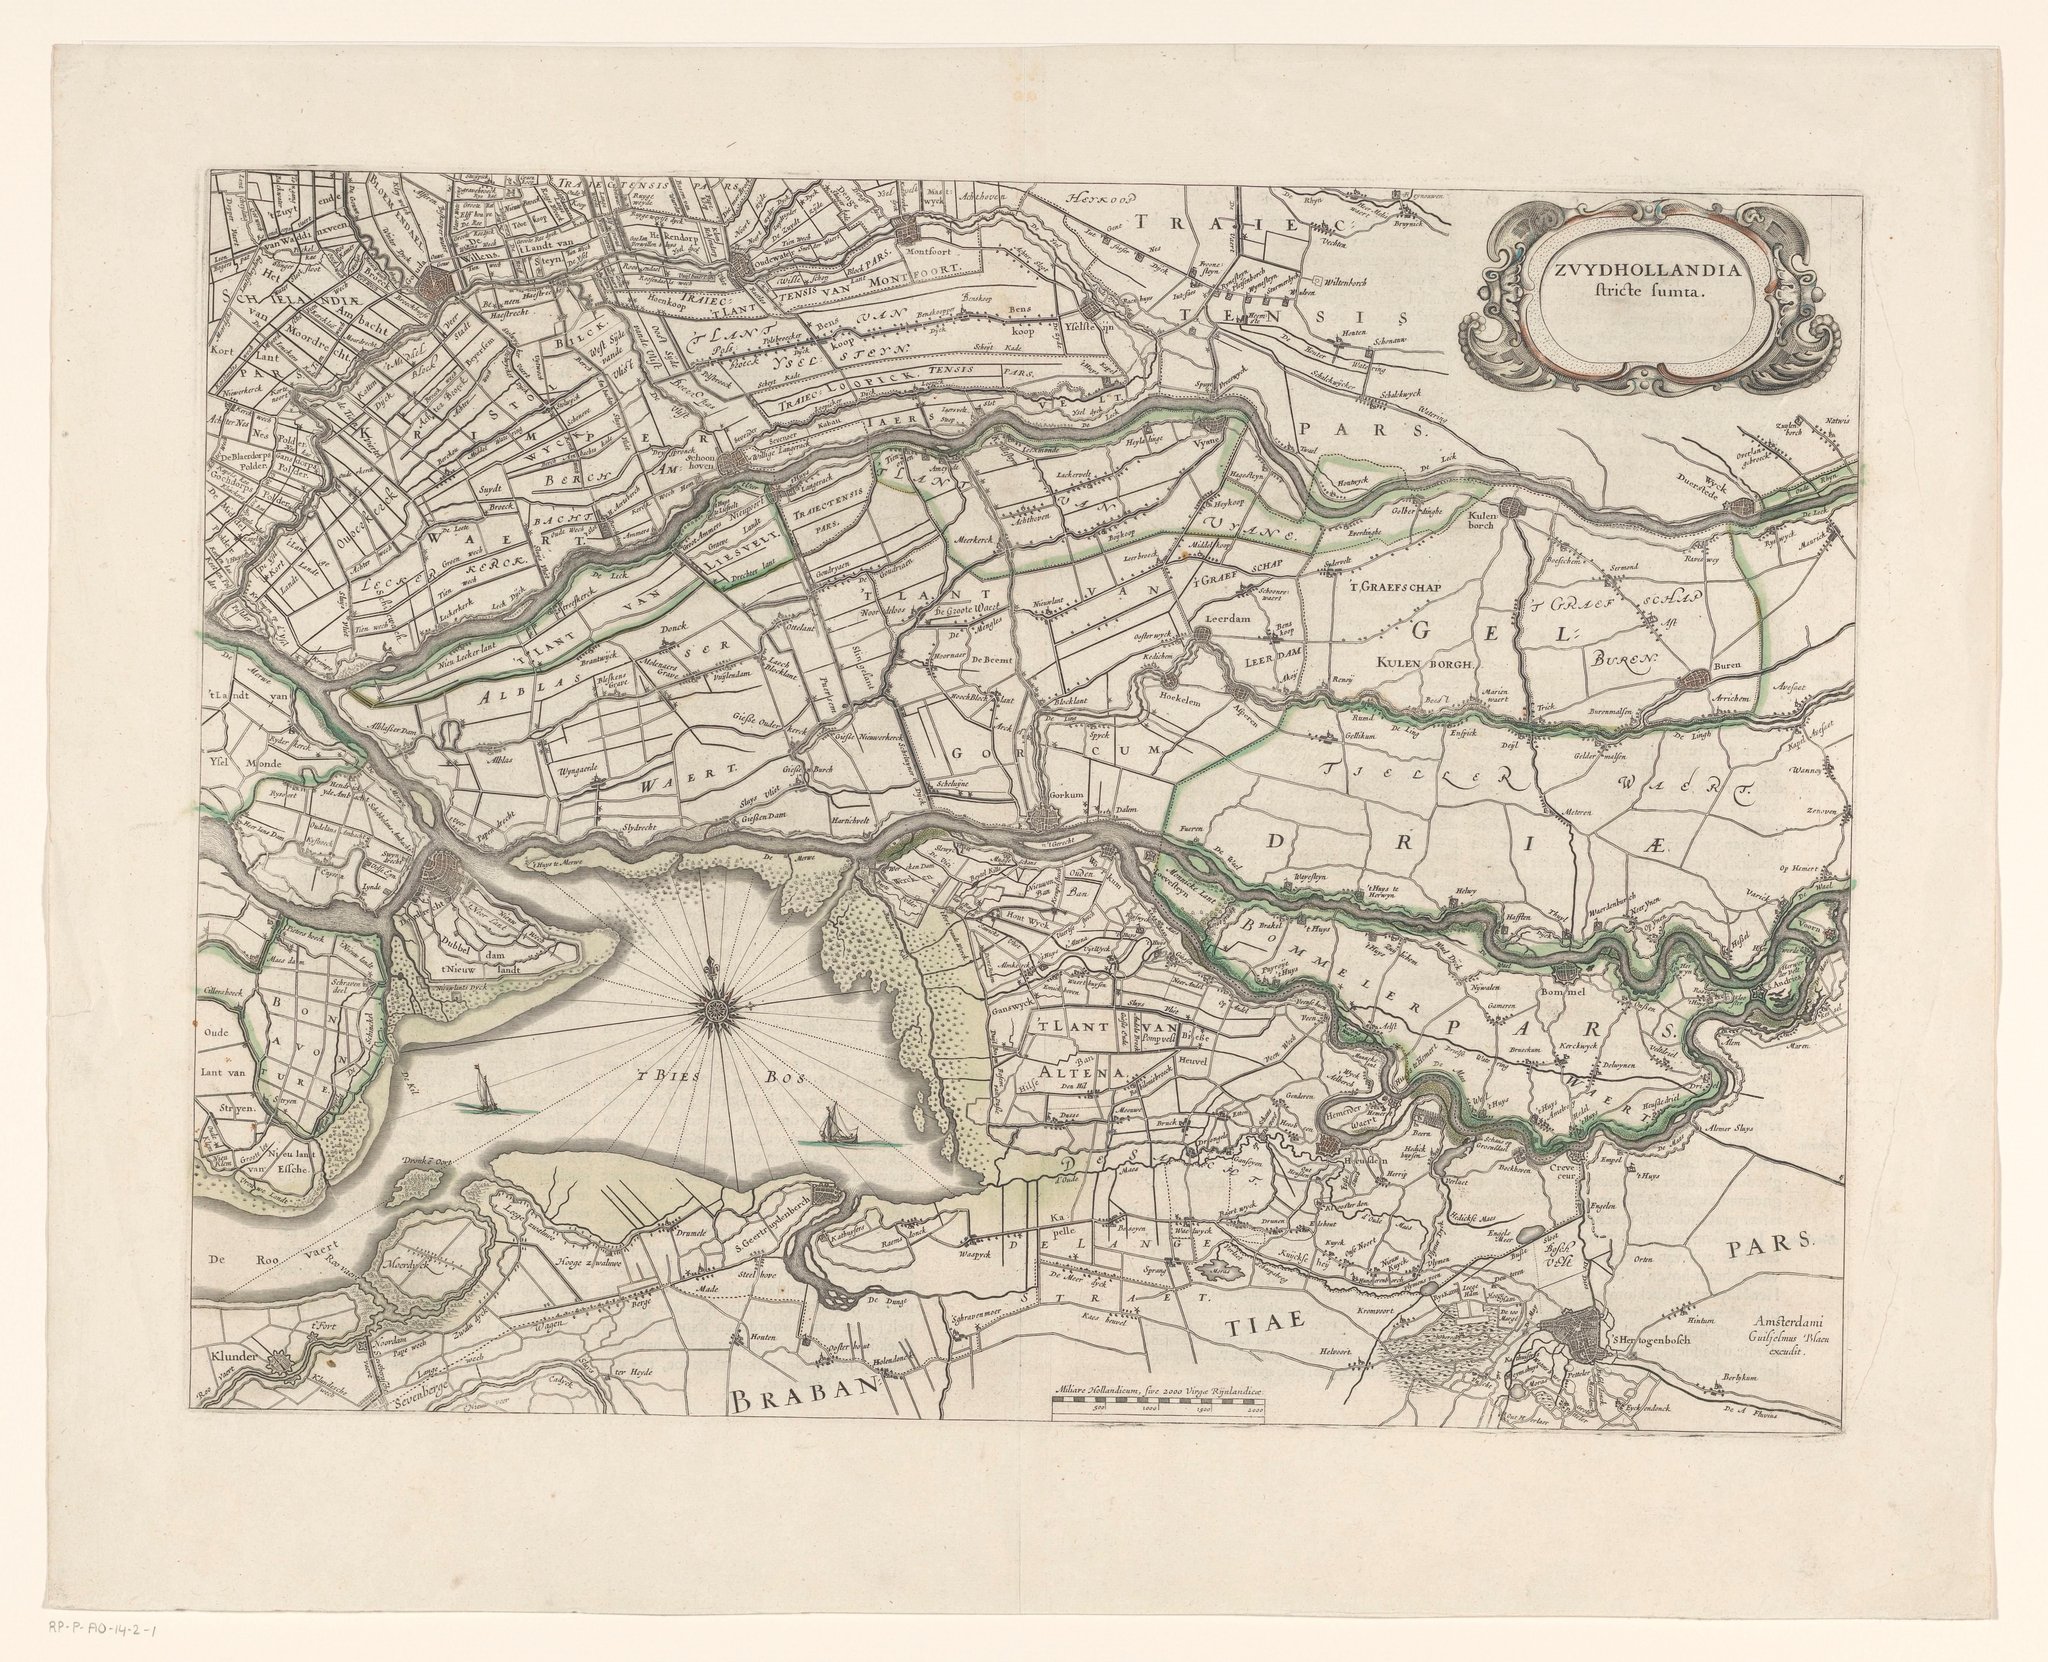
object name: map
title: Zuydhollandia stricte sumta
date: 1631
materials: paper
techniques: engraving, etching, hand coloring, letterpress printing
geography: amsterdam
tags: maps of separate countries or regions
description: Prent gebruikt in: Blaeu, Johannes Willemszoon. J. Blaeus grooten atlas oft wereltbeschyving, in welcke 't aerdryck, de zee, en hemel, wort vertoont en beschreven. 9 delen. Amsterdam: Johannes Willlemszoon Blaeu, 1664-1665, dl. 3 (1664).